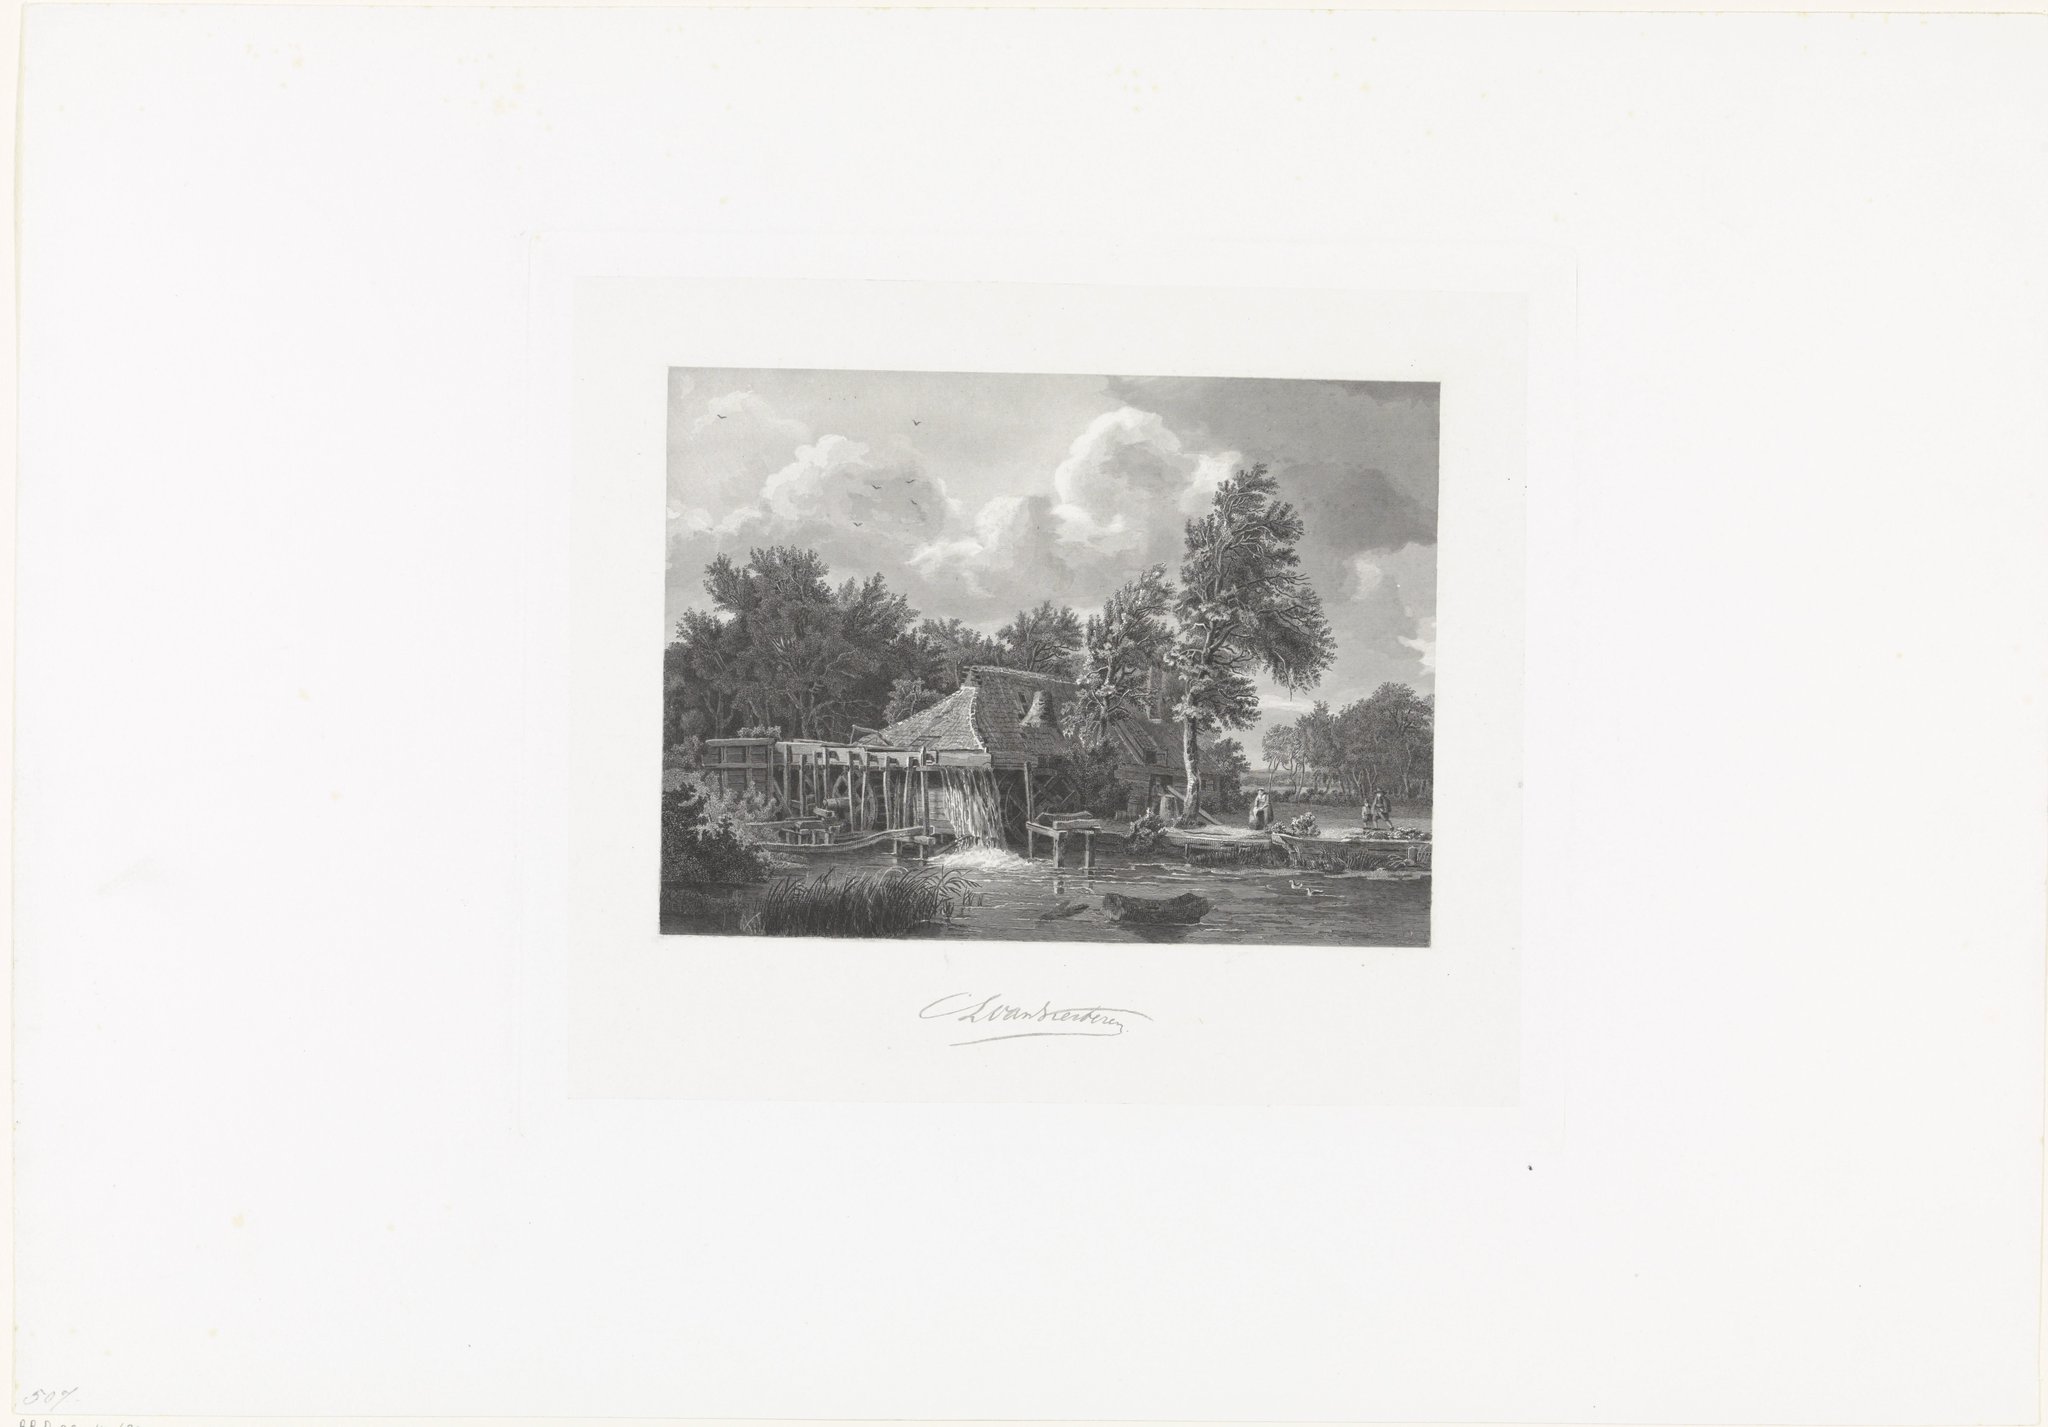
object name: print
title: Watermolen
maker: christiaan lodewijk van kesteren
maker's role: print maker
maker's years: 1832-1897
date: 1861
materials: paper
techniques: engraving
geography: amsterdam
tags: winds, brook, watermill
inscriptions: collector's mark: Lugt 2165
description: Deze prent is als illustratie gebruikt in: Christiaan Lodewĳk van Kesteren en Willem Jacob Hofdĳk. Museum Van der Hoop : 12 staalgravures naar de uitnemendste en belangrijkste schilderijen. Amsterdam : Wed. J.C. van Kesteren & Zoon. 1861.